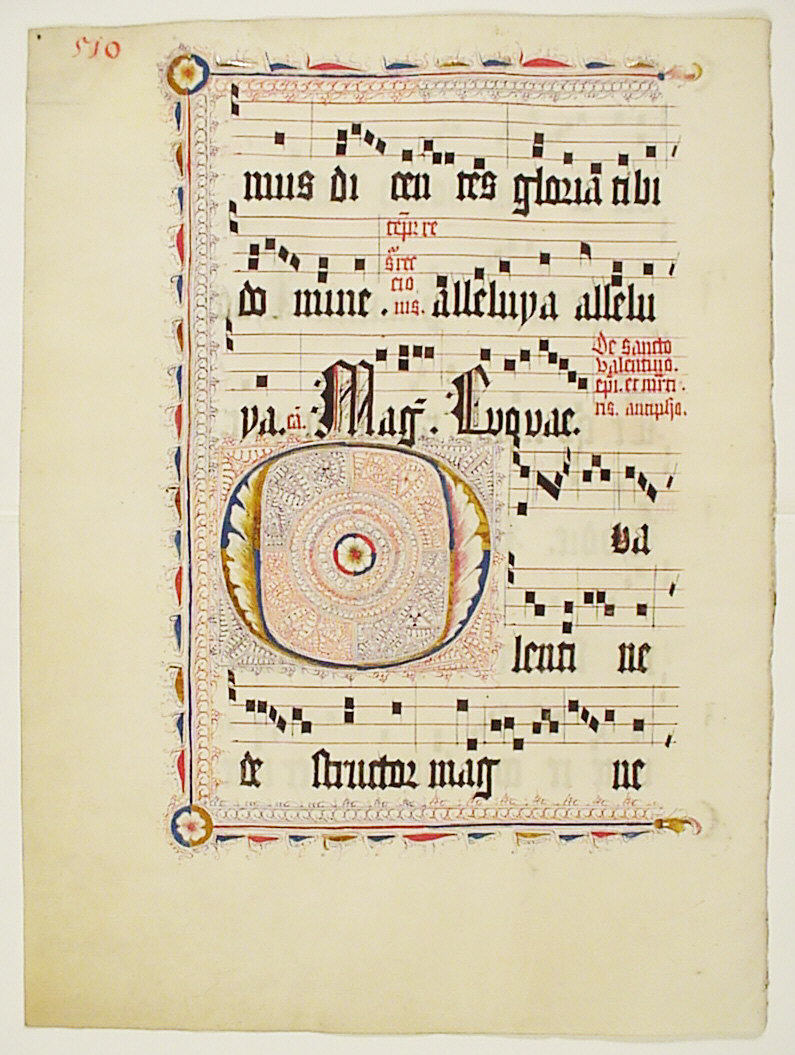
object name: antiphonary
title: Manuscript Leaf with Initial O, from an Antiphonary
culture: german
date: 1426-1450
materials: ink, metal leaf, parchment, paint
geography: germany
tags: music